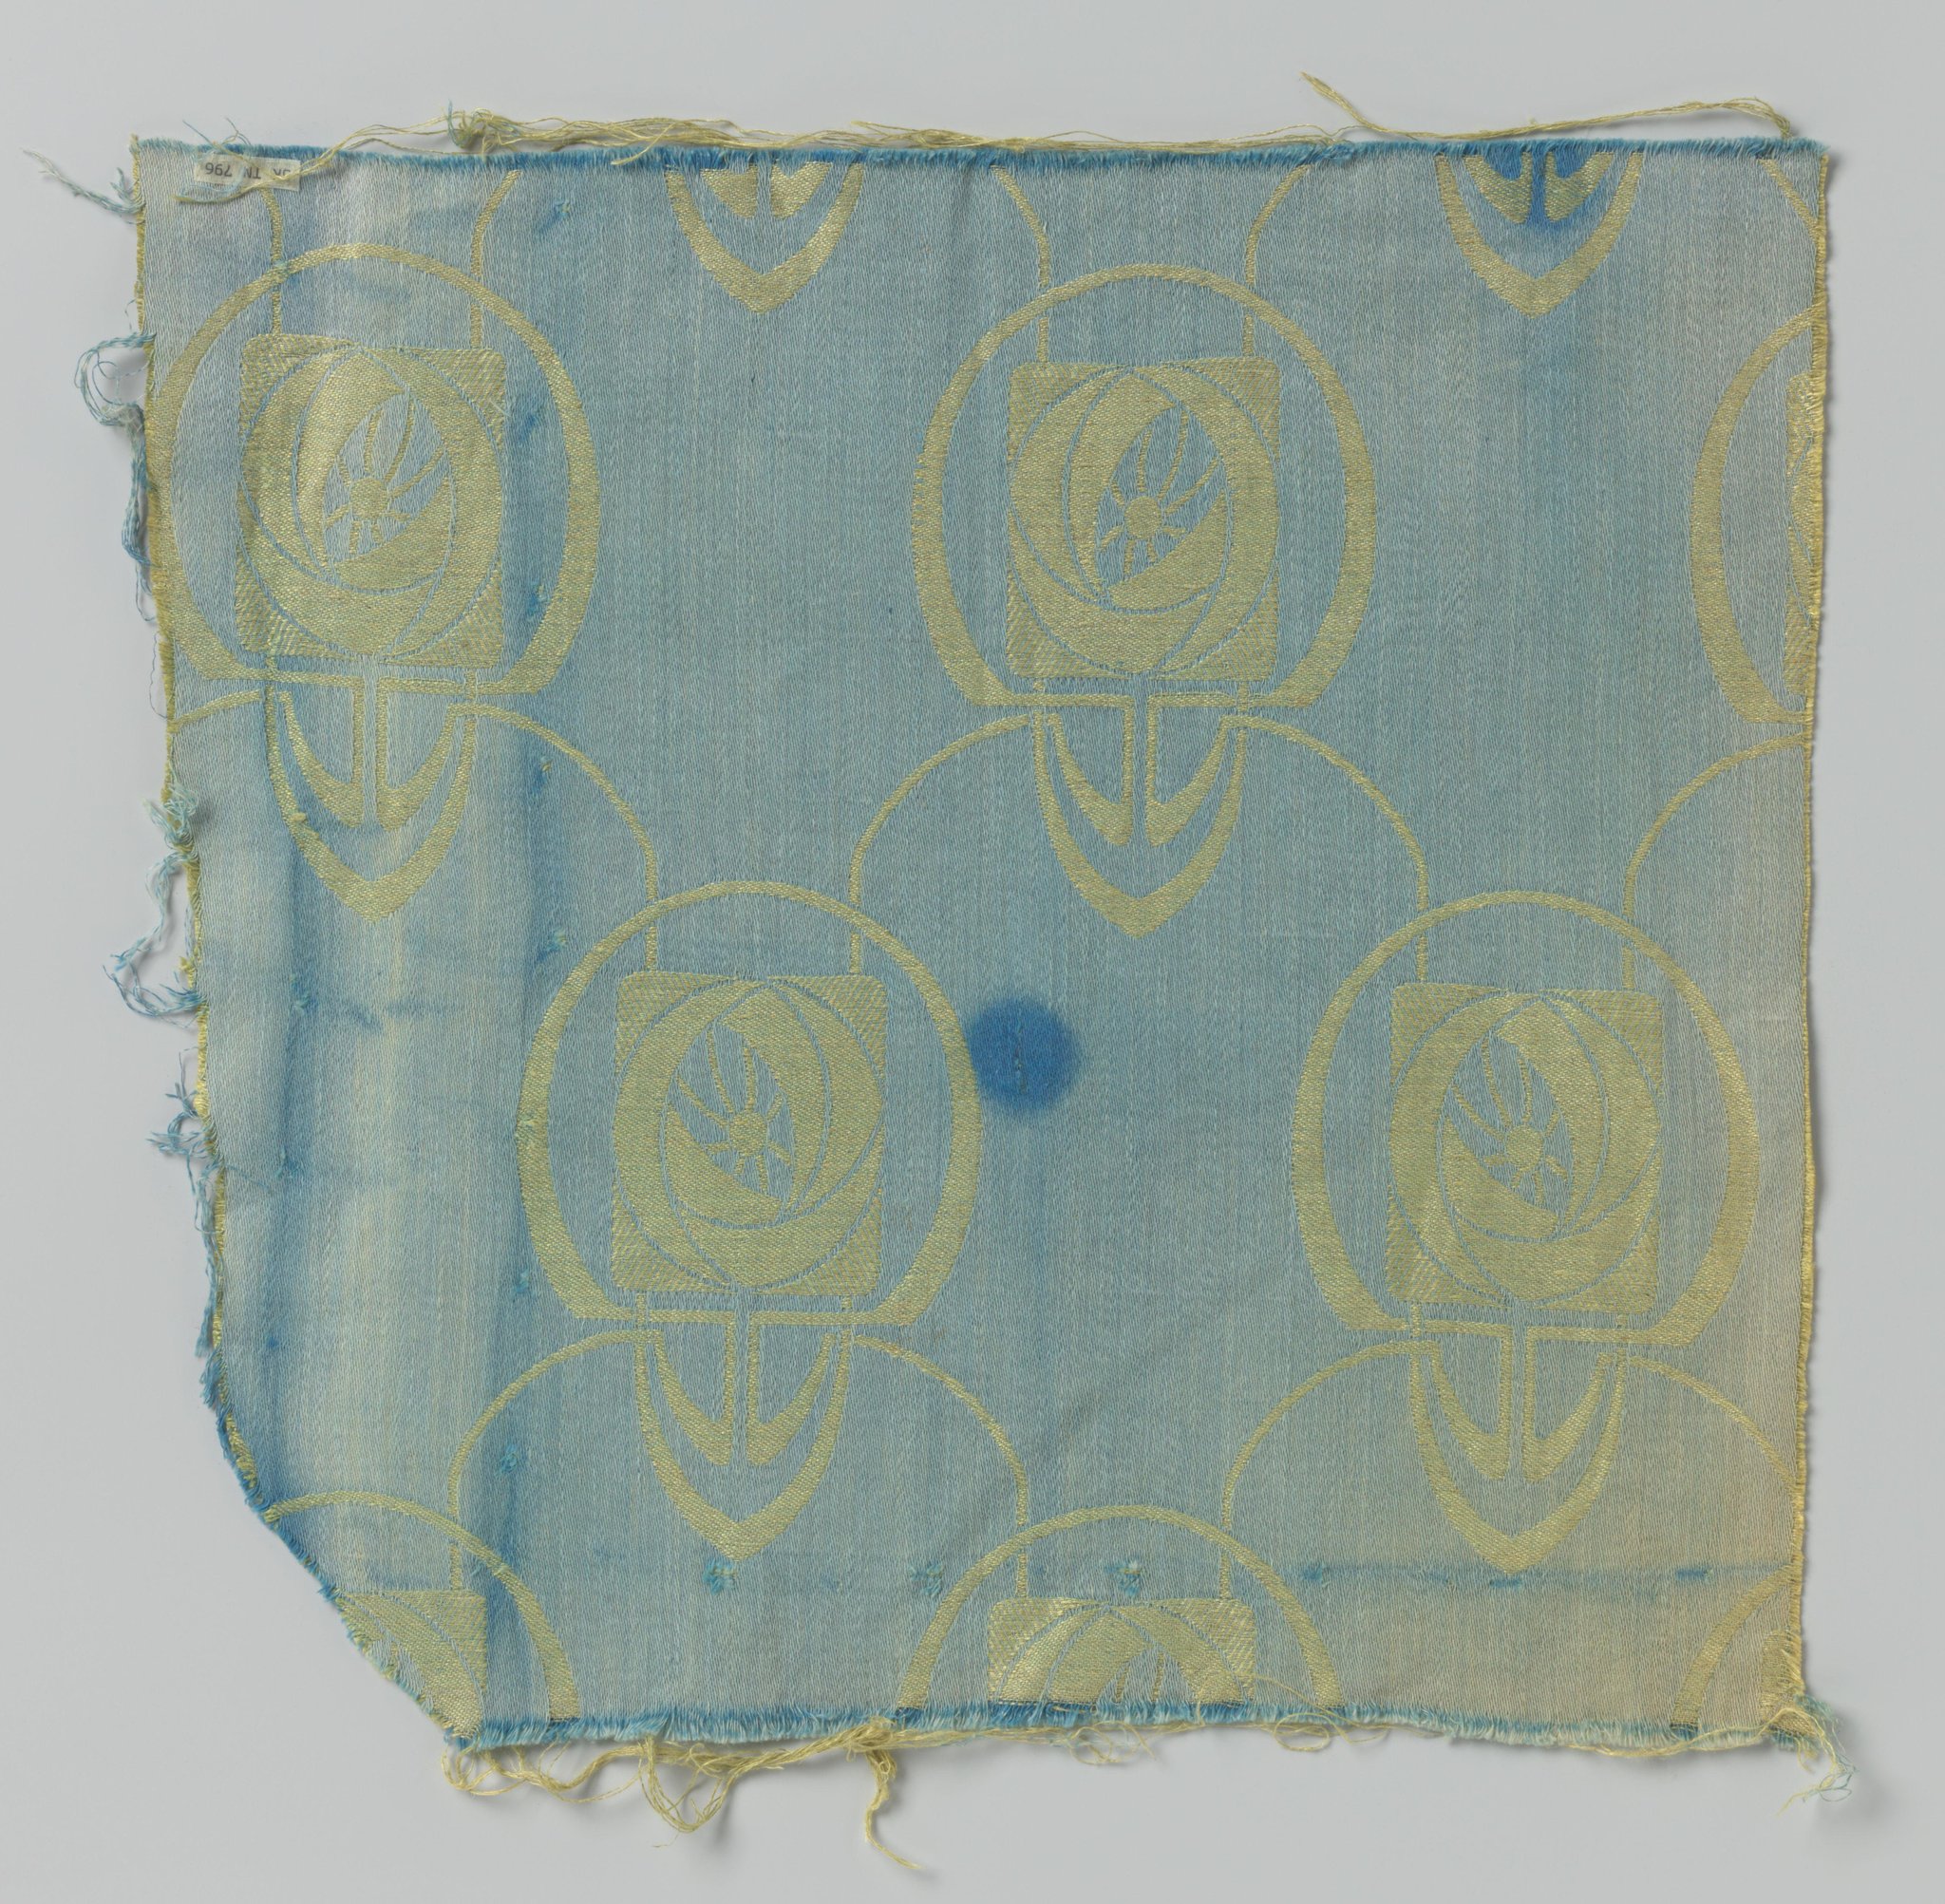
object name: tick covering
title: Fragment beddentijk van satijndamast met Art-Déco-motief in groen op blauwe grond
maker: Anonymous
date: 1919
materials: cotton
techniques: damask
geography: netherlands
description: Fragment beddentijk van satijndamast met Art-Déco-motief in groen op blauwe grond.